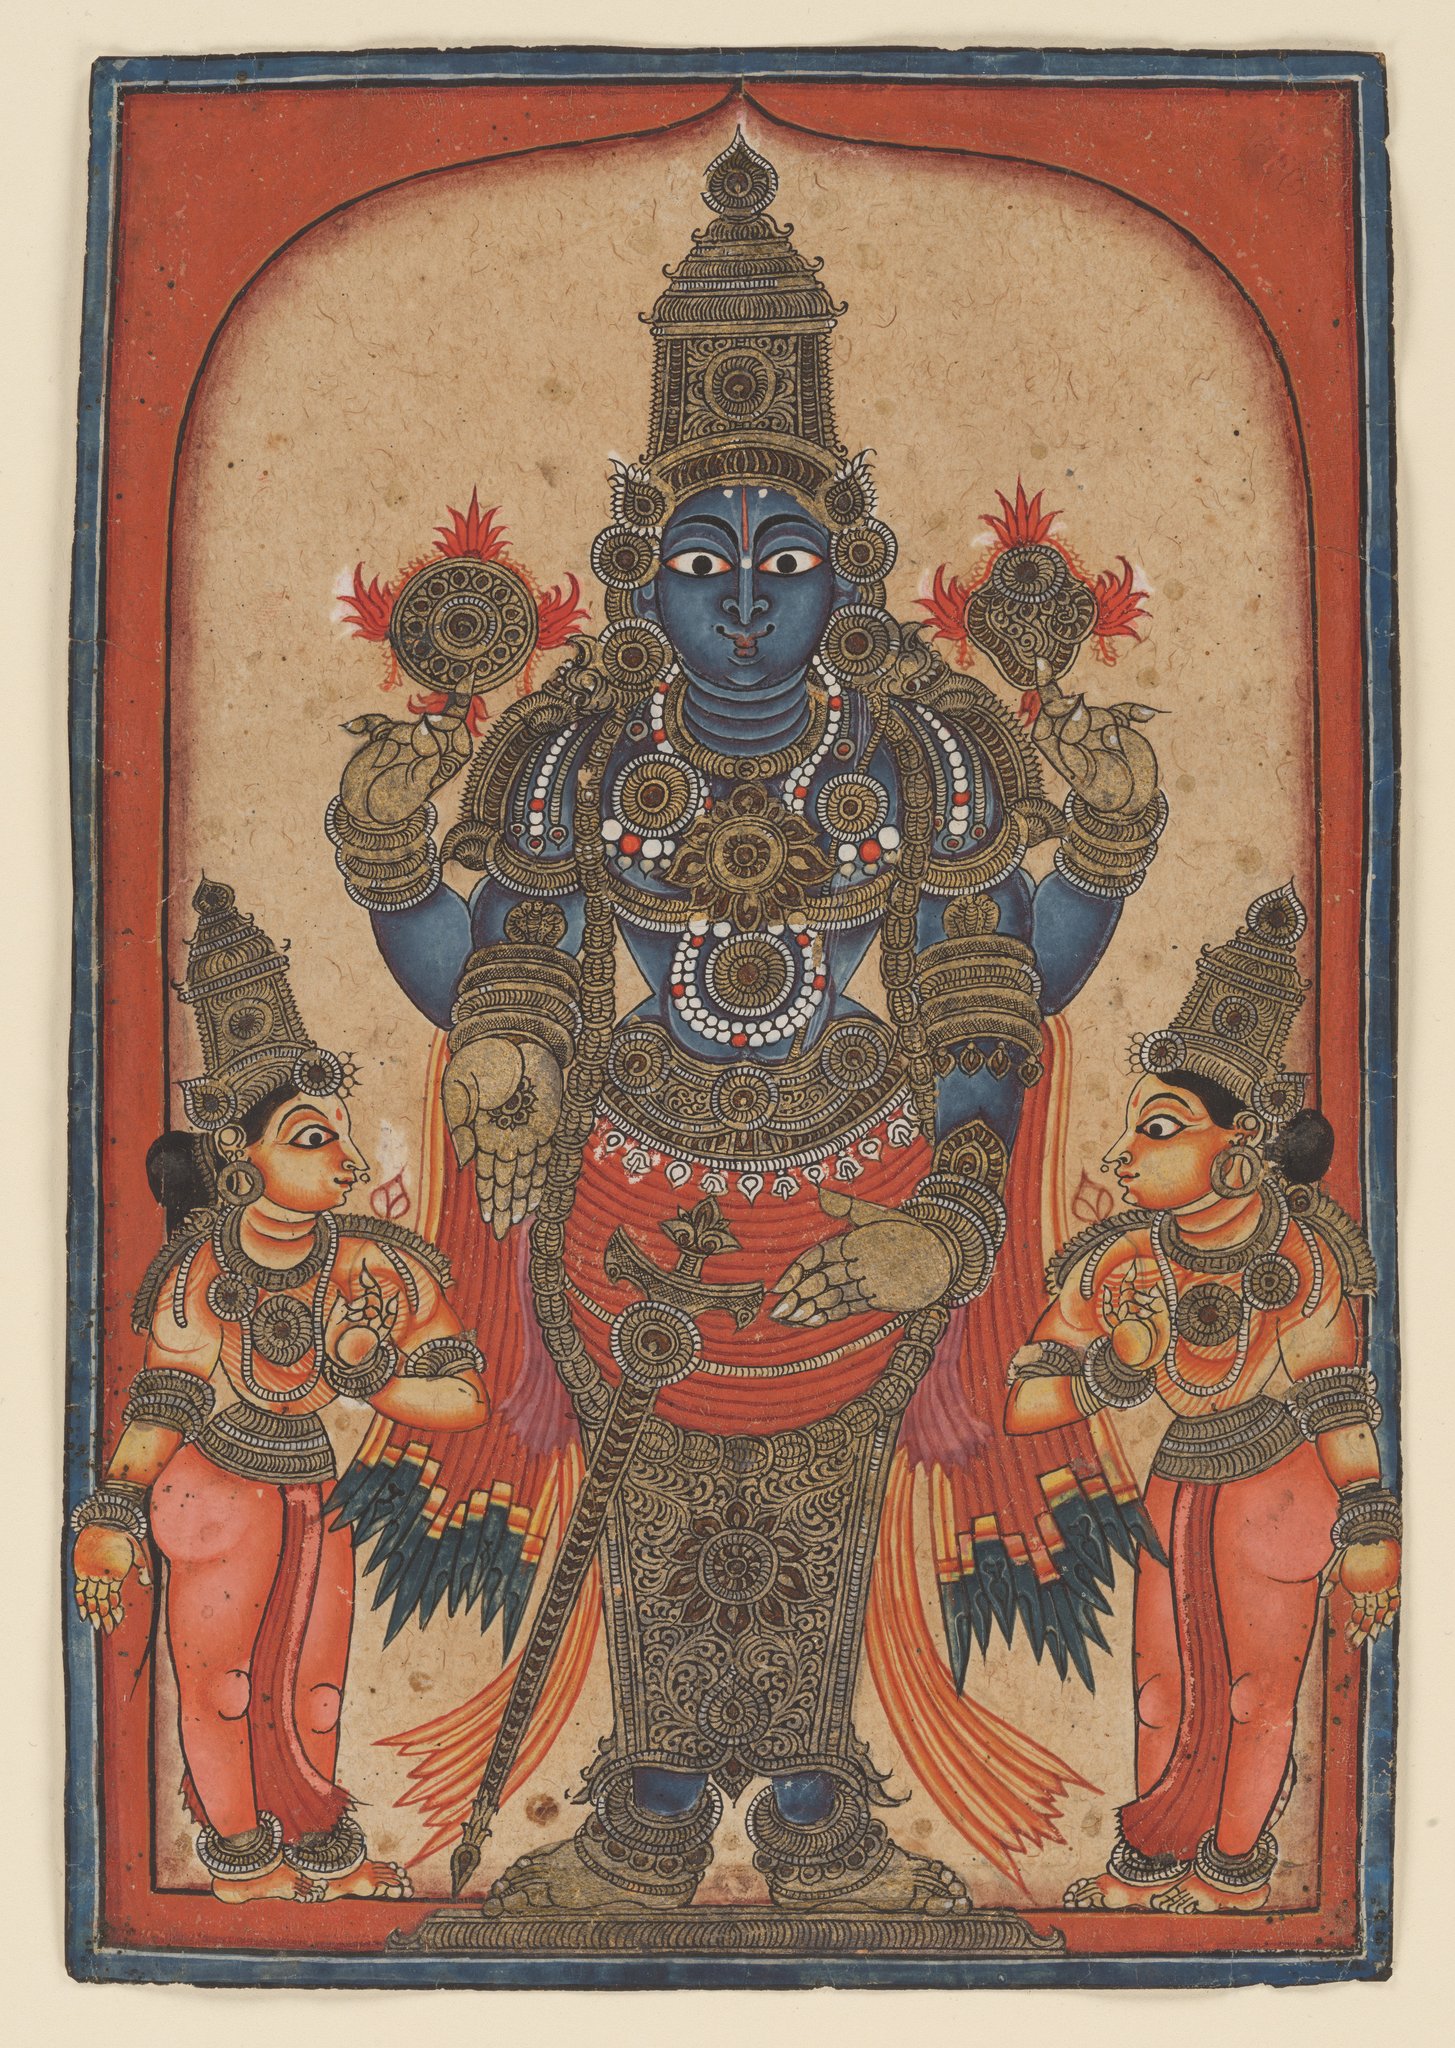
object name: painting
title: Vishnu Venkateshvara, Lord of Tirupati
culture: south indian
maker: tirupati school, south india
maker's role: artist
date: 1767-1800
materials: paper, silver, watercolor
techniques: hand coloring